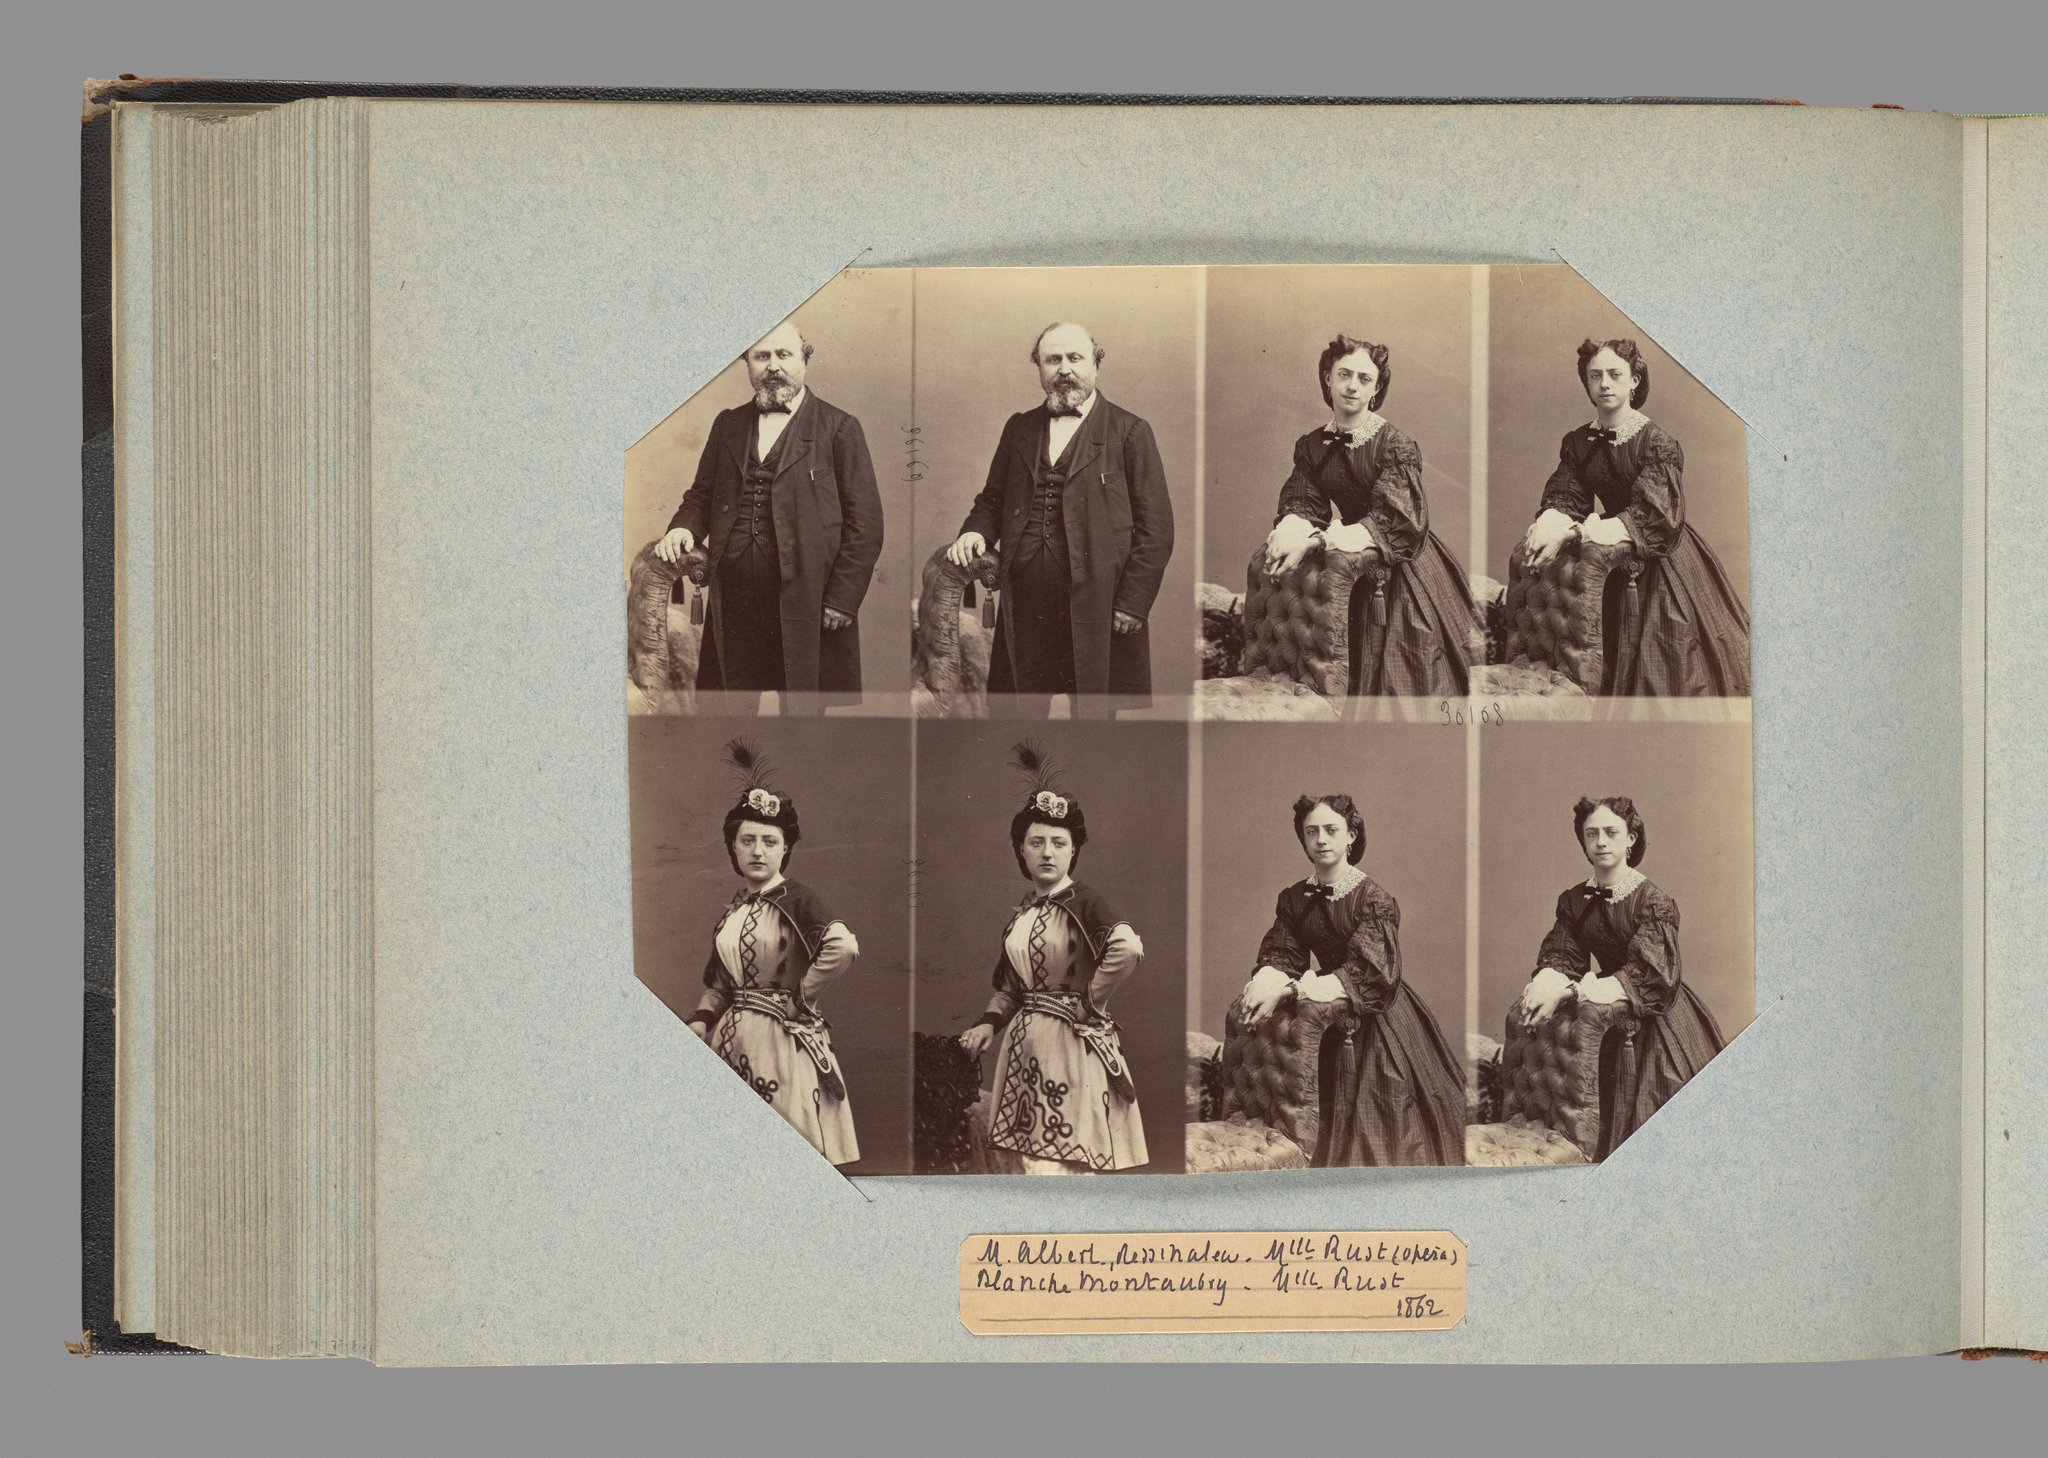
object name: photograph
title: M.Albert; Mlle Rust; Blanche Montaubry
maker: andré-adolphe-eugène disdéri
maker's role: artist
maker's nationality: french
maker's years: 1819-1889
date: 1862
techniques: albumen silver print, glass negative